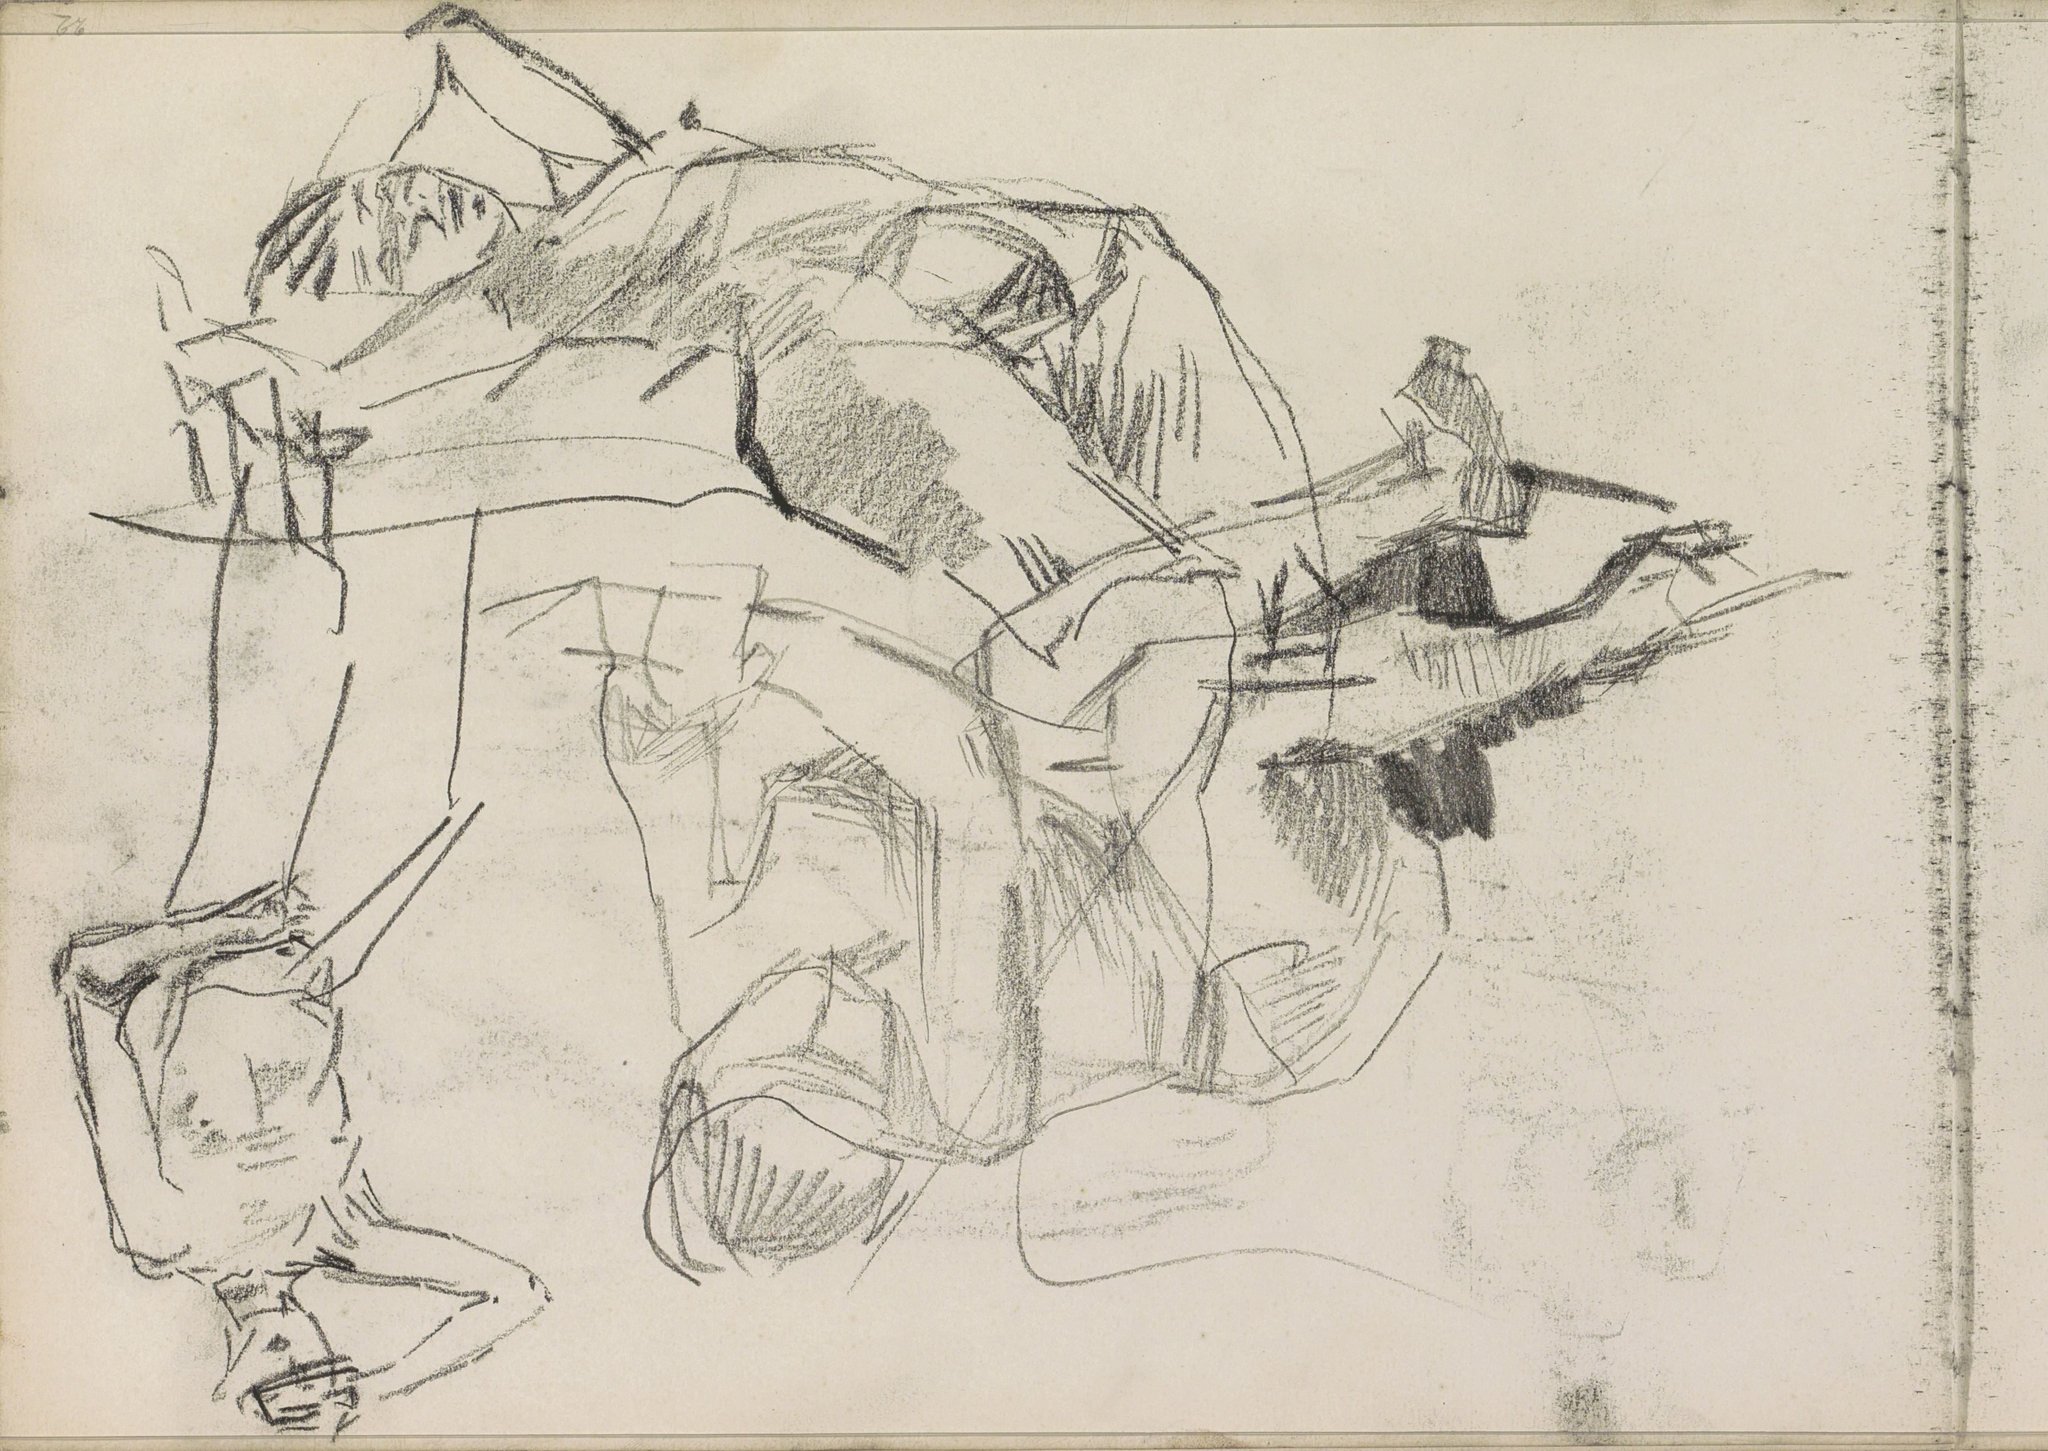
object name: sketchbook leaf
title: Vrouwelijke naakten in verschillende houdingen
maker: isaac israels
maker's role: draughtsman, painter, print maker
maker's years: 1865-1934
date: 1892-1900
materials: chalk, paper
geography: the hague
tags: standing figure - aa - female human figure, lying figure - aa - female human figure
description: Blad 3 verso uit schetsboek VIII met 12 bladen.